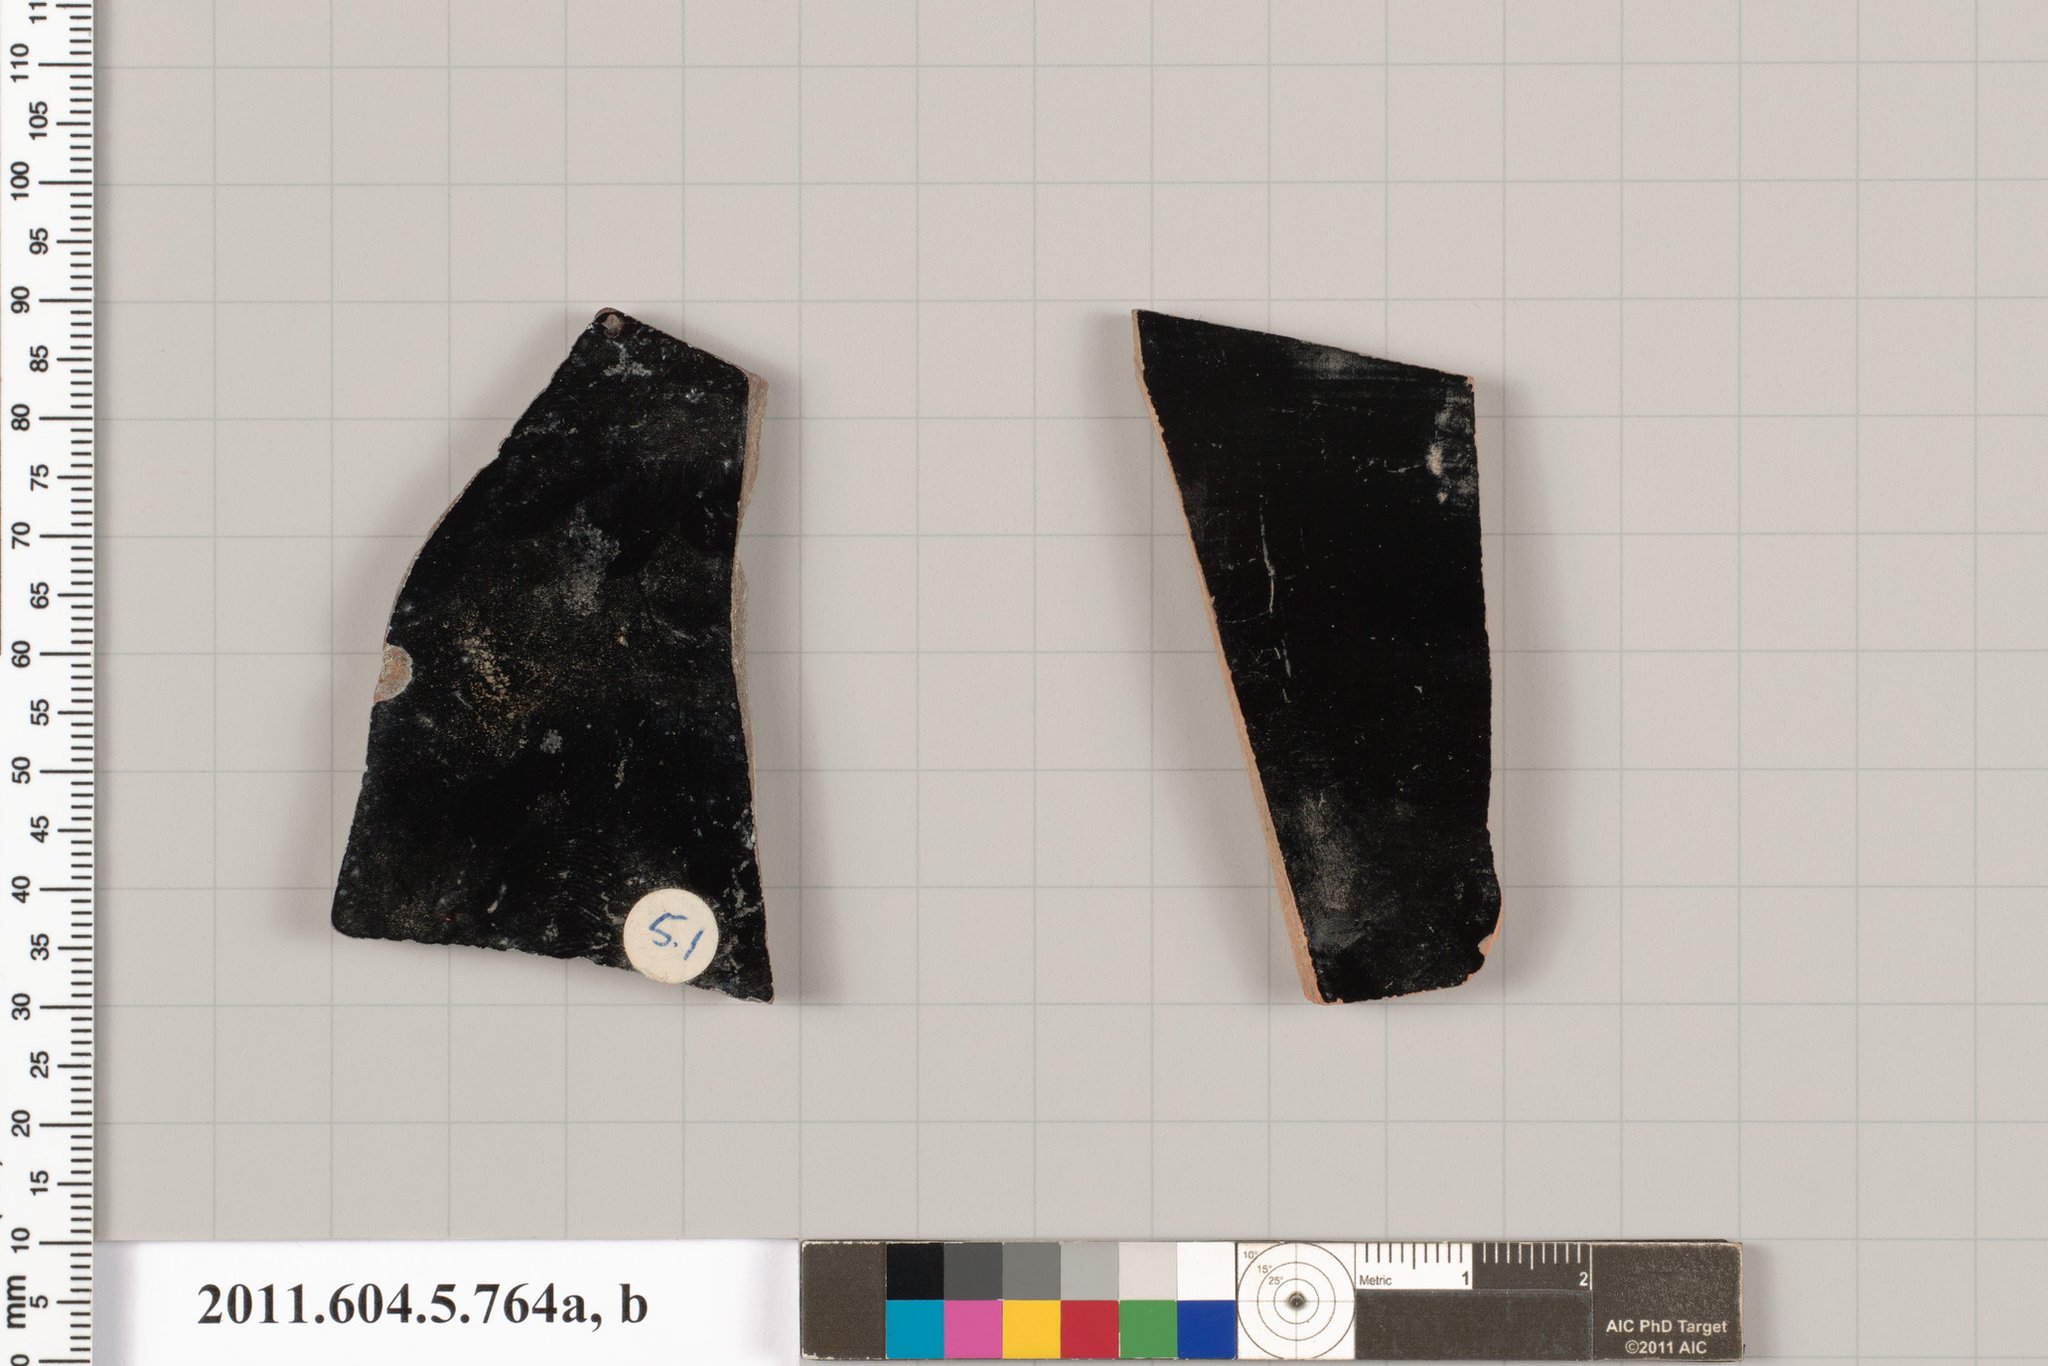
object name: kylix fragment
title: Terracotta fragments of kylikes (drinking cups)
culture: greek, attic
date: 600-401 BCE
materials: terracotta